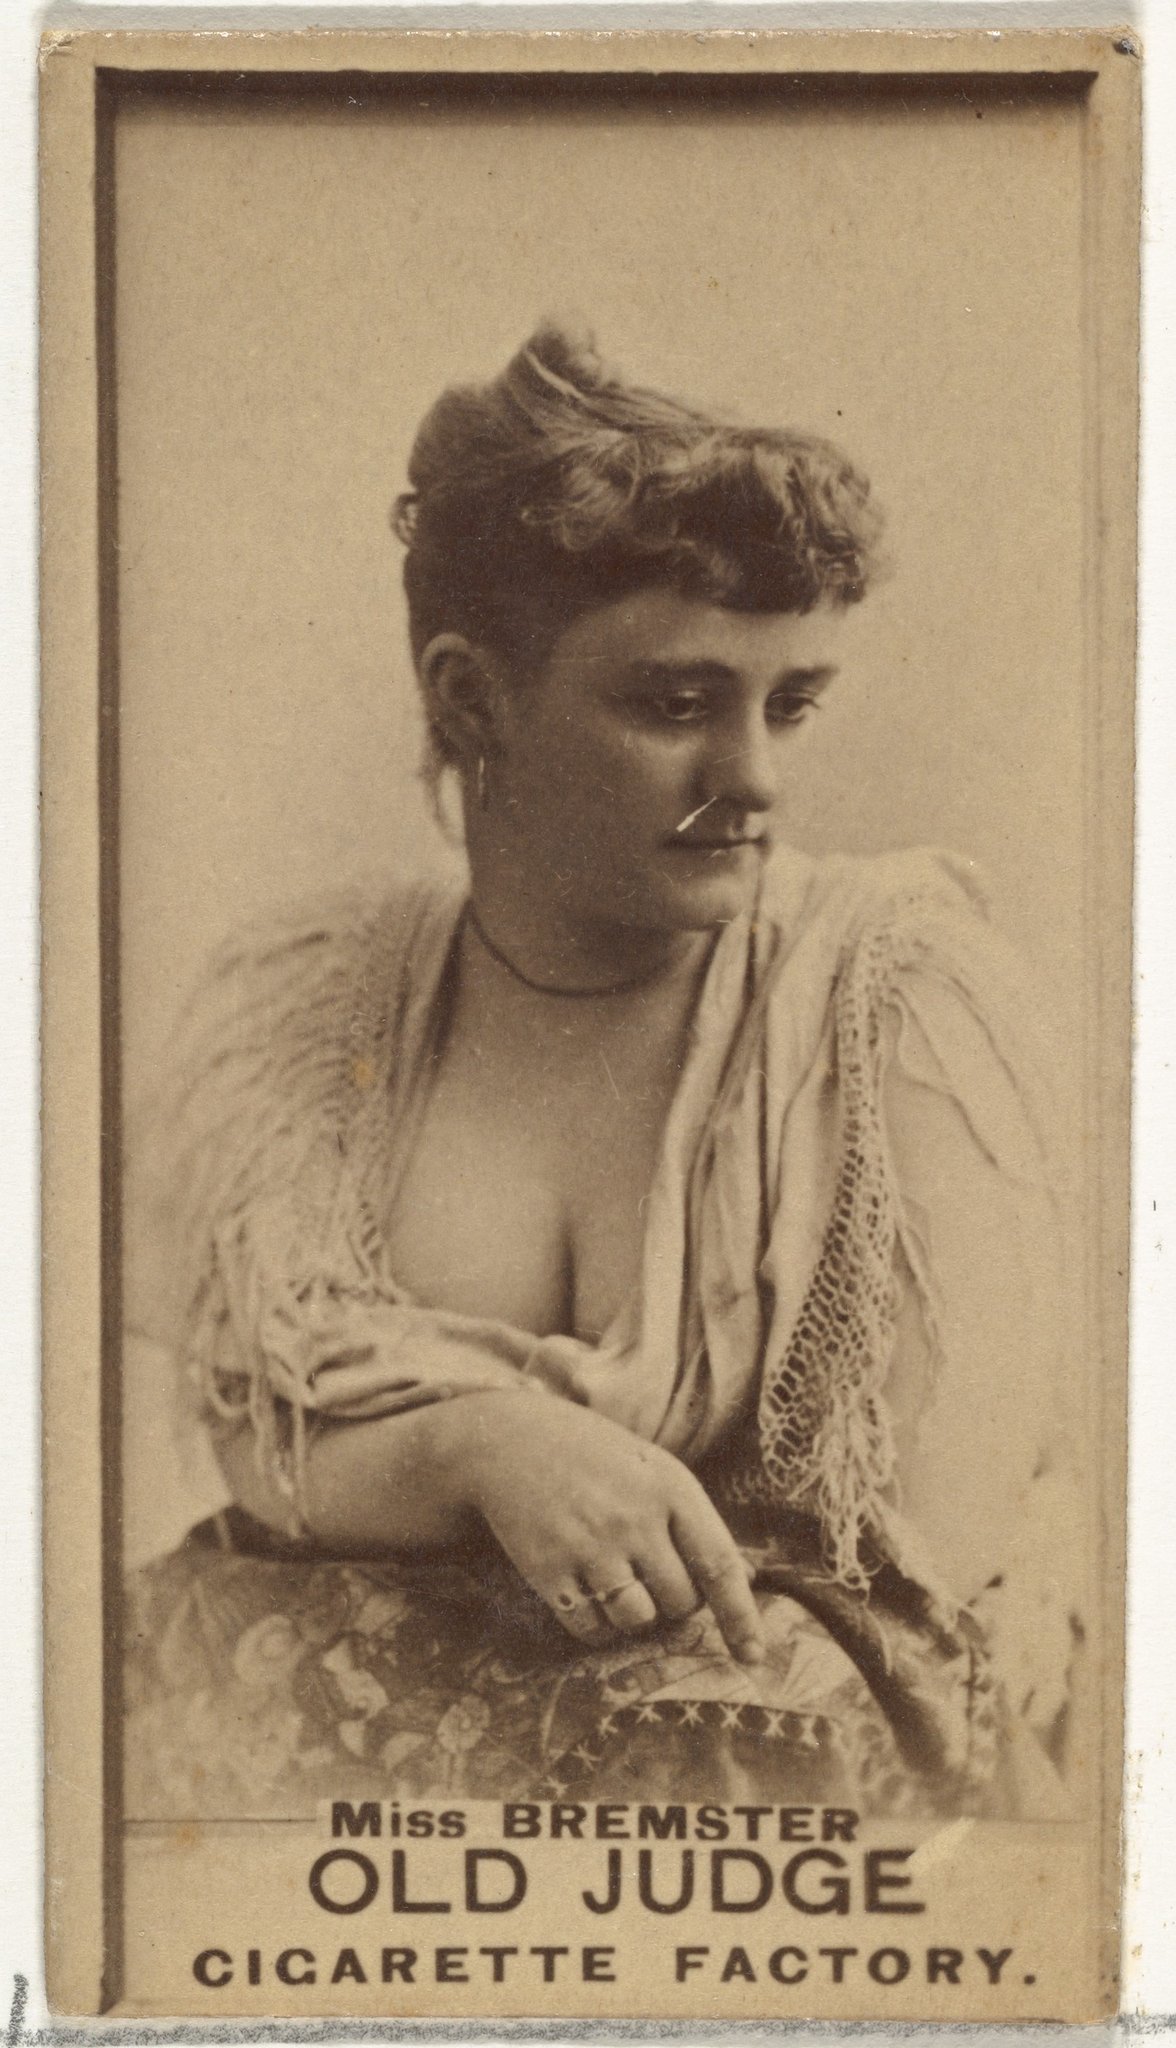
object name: photograph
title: Miss Bremster, from the Actors and Actresses series (N171) for Old Judge Cigarettes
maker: goodwin & company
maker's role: publisher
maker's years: 1850-1950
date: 1886-1890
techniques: albumen silver print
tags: portraits,women,actresses